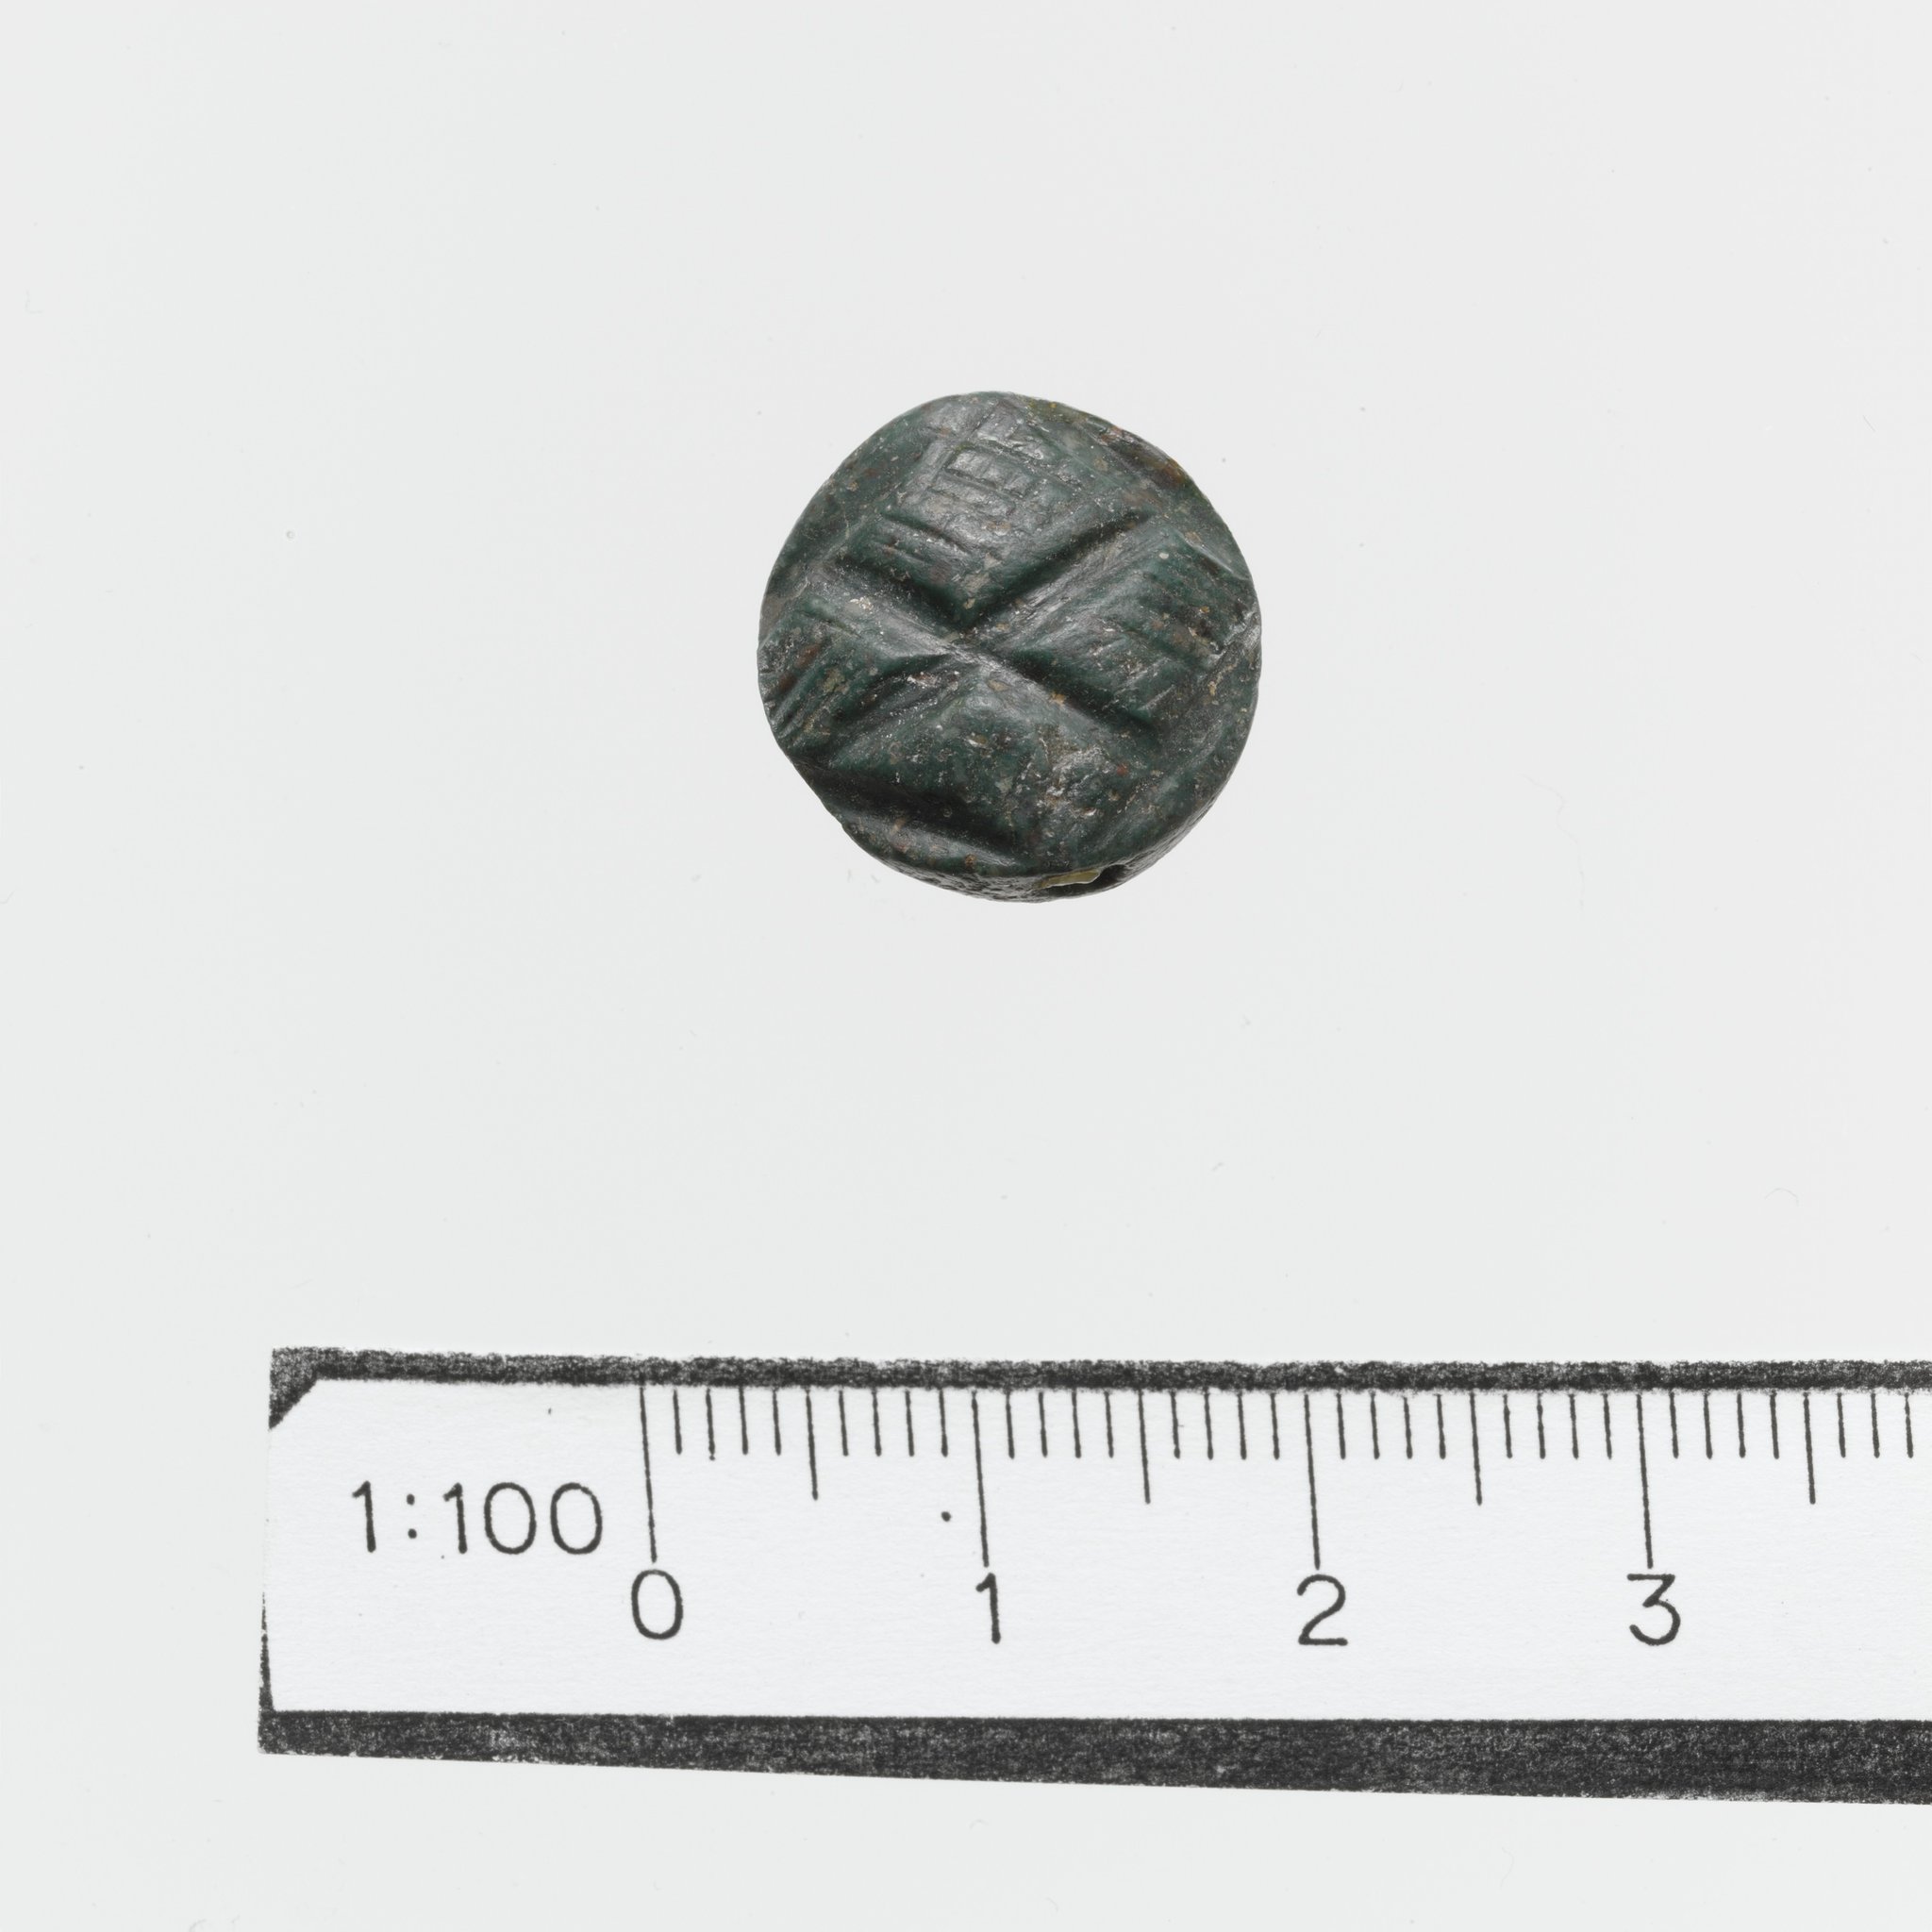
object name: seal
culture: minoan, crete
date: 2000-1450 BCE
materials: stone